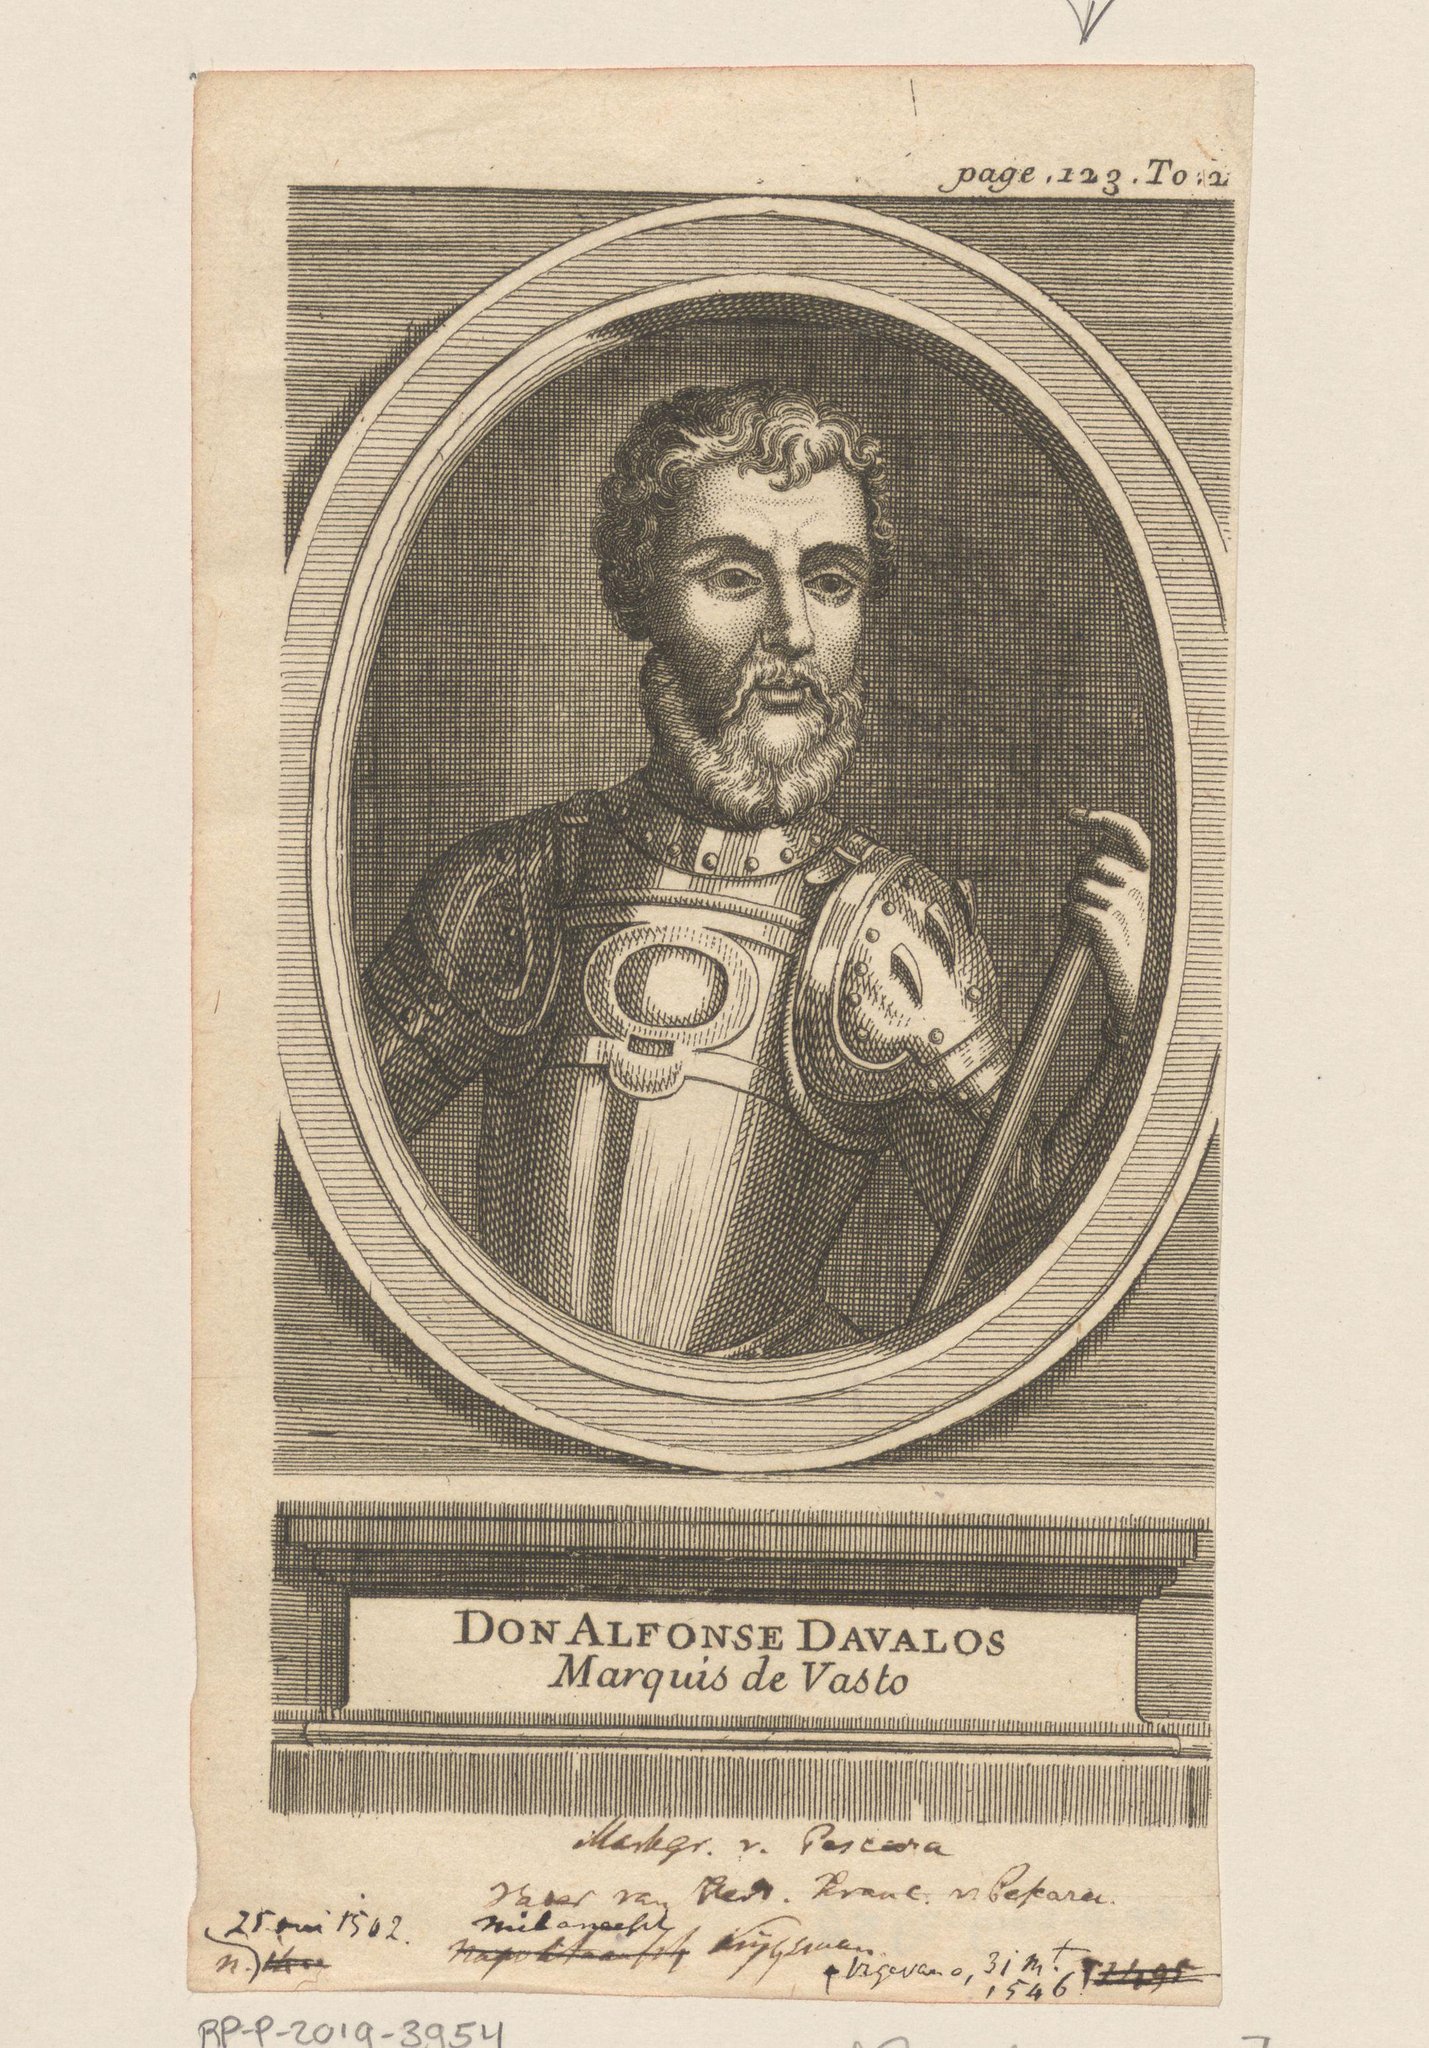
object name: print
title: Portret van Alfonso d'Avalos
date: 1715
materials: paper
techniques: engraving, etching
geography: brussels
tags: armour, historical persons, baton of general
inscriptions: inscription: ‘[...]’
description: Prent uit: Leti, Gregorio. La vie de l'empereur Charles V. Brussel: Josse de Grieck, 1715, dl. 2, p. 123. Prent ook verschenen in de 1726-editie van dit werk, door dezelfde uitgever.